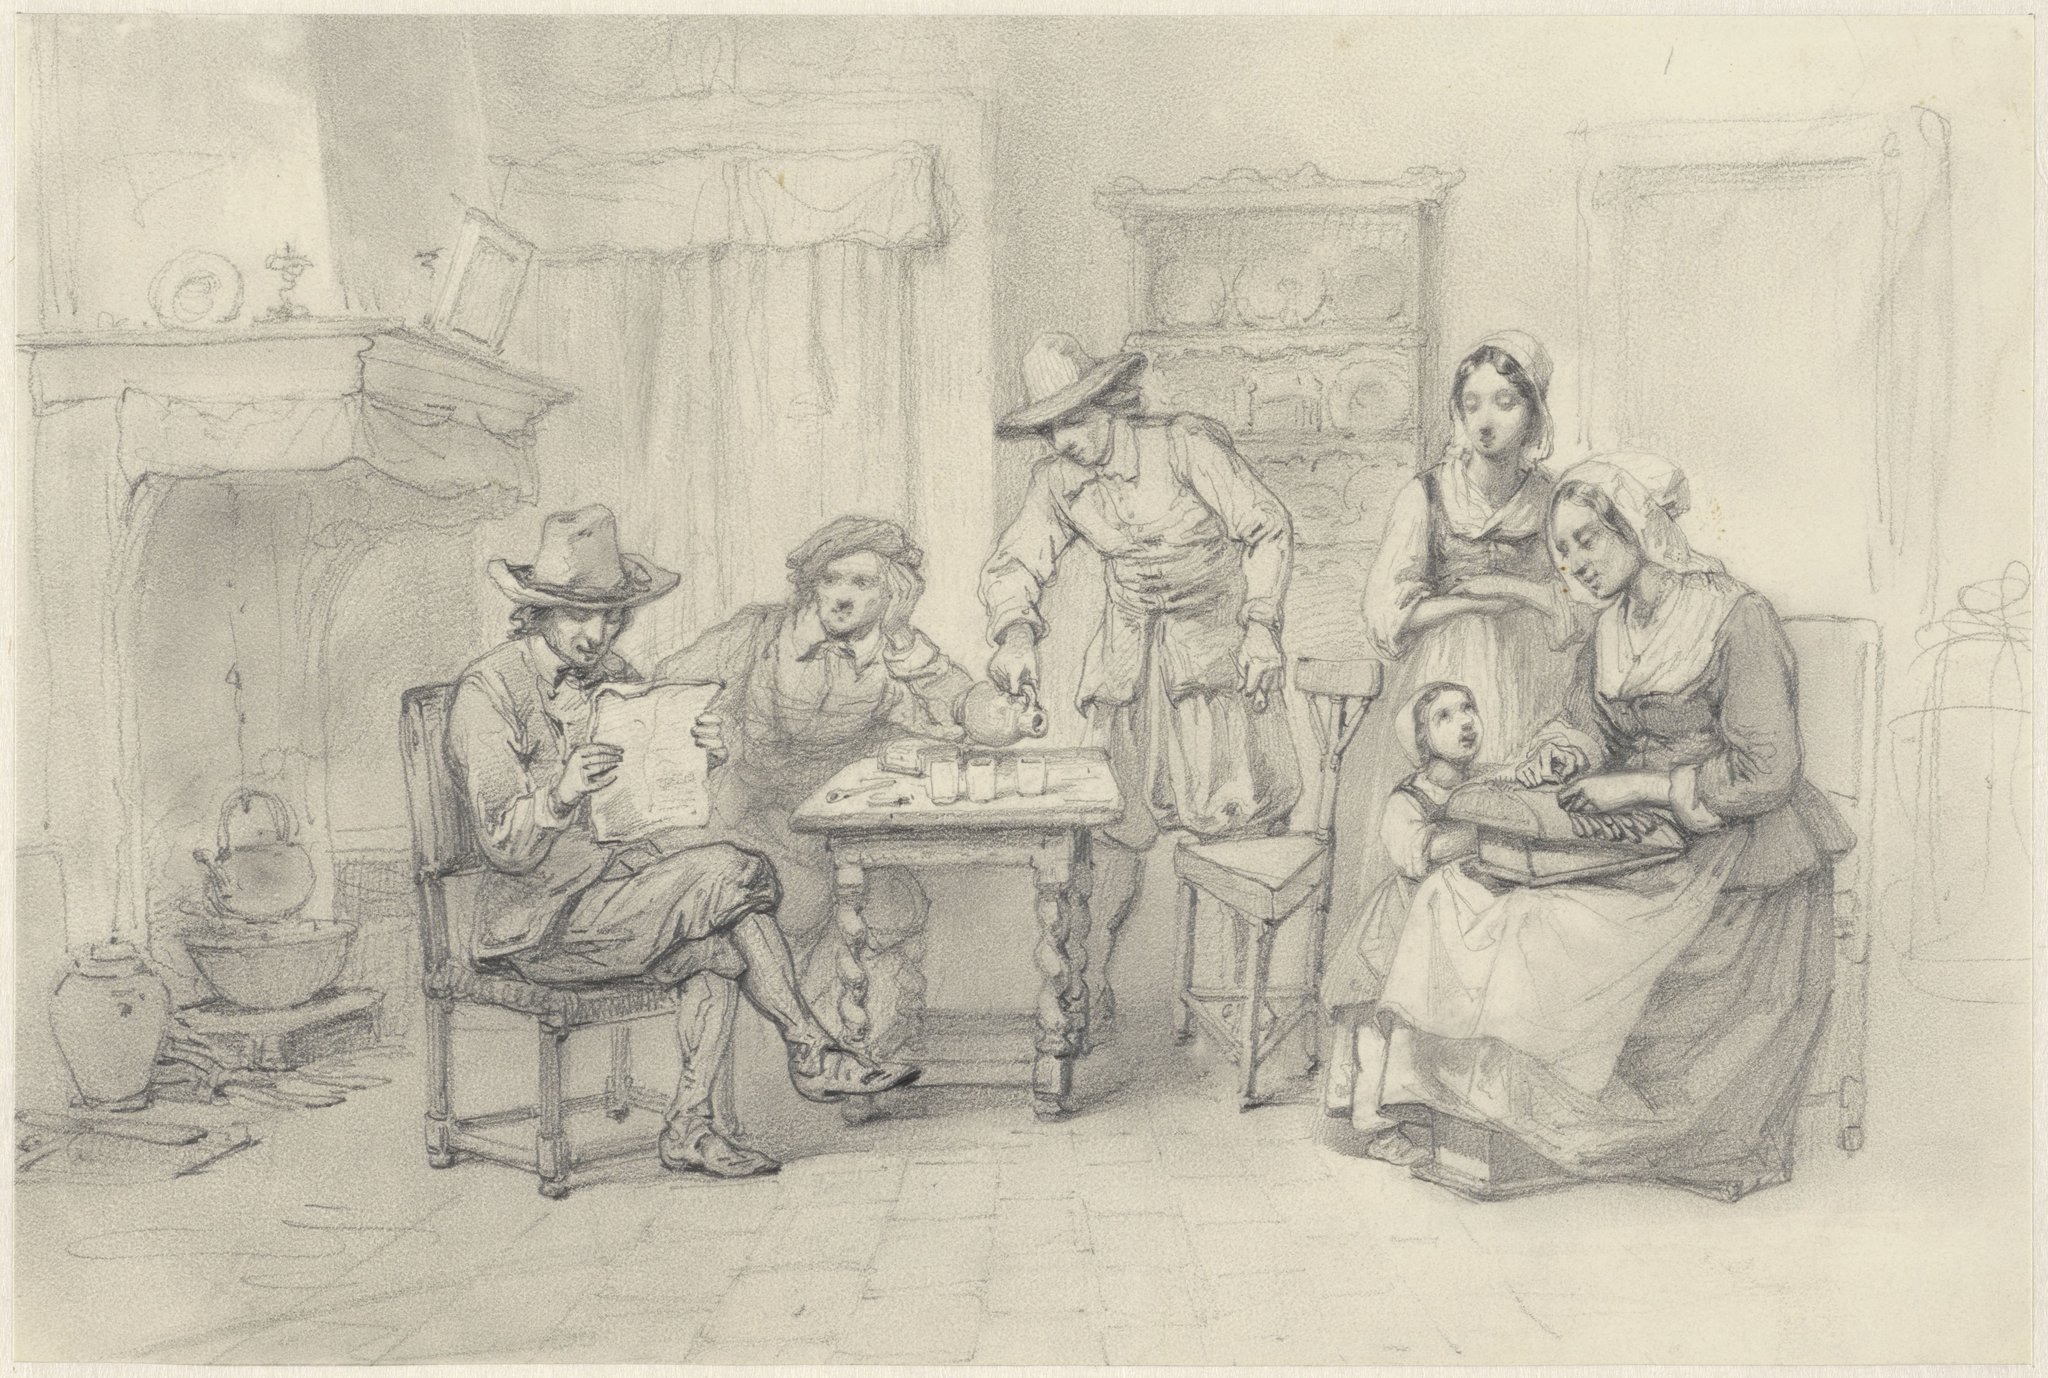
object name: drawing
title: Historisch interieur met figuren rond een tafel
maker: willem pieter hoevenaar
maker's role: draughtsman, painter, print maker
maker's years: 1808-1863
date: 1818-1863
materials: paper, pencil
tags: family group, especially parents with their child(ren), interior of the house